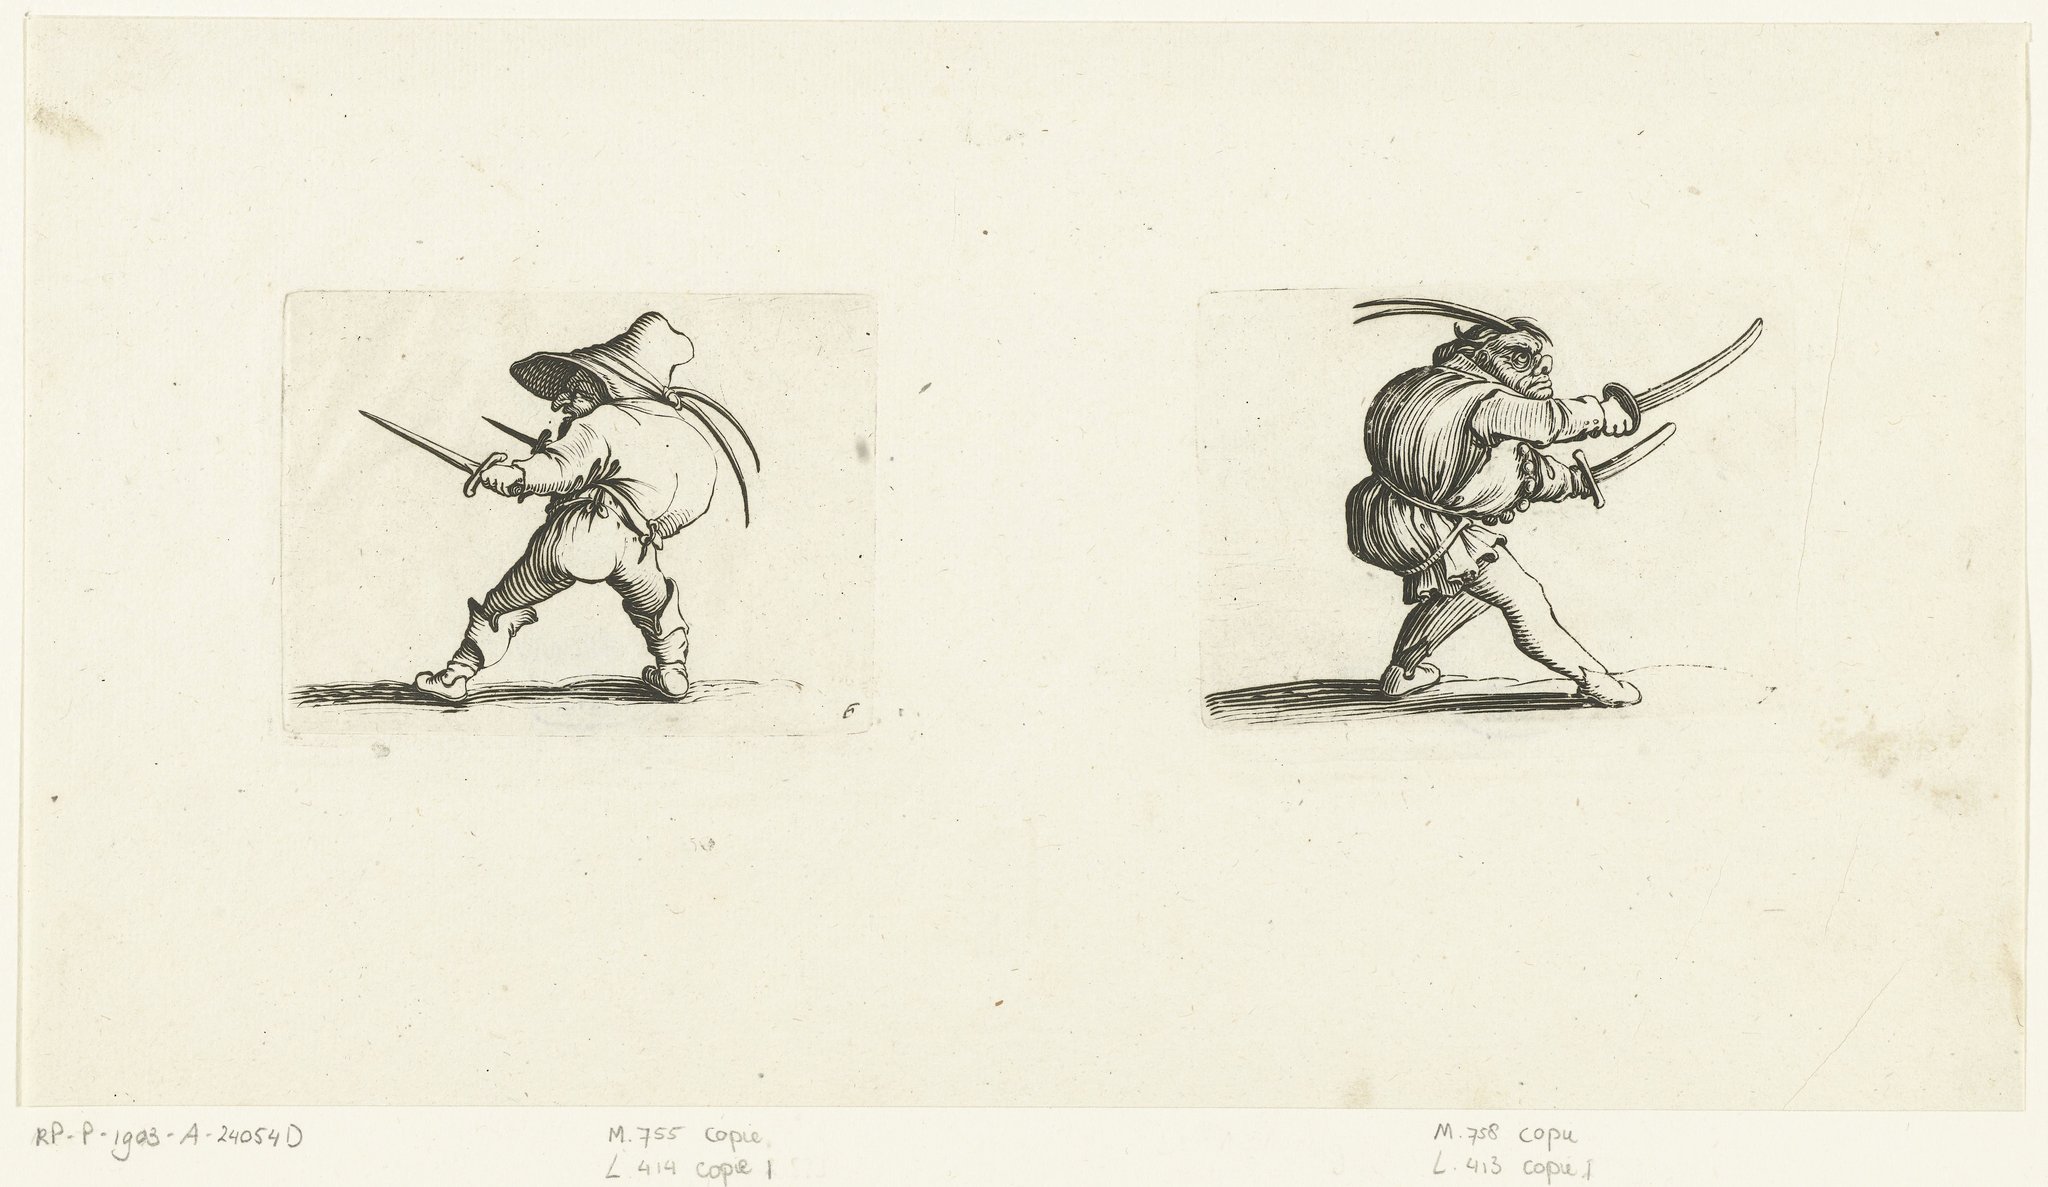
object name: print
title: Kleine mensen en gebochelden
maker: abraham bosse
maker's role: draughtsman, print maker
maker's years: 1602-1676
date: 1621-1676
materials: paper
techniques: engraving, etching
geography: paris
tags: little people, hacking and thrusting weapons: dagger, hacking and thrusting weapons: sword, hunchback, human beings (legendary or not) of abnormal proportions, size, strength, etc.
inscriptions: collector's mark: Lugt 2228a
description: Links: kleine mens (karikatuur), min of meer op de linkerzijde gezien, met een gebochelde rug, een hoed met twee veren op het hoofd, in de rechterhand en in de linkerhand een dolk. Rechts: groteske figuur, op de rechterzijde gezien, met een gebochelde rug, een muts met twee veren op het hoofd, in de rechterhand en in de linkerhand een zwaard. Deze beide prenten, naast elkaar op 1 blad gedrukt, zijn onderdeel van een serie van 21 prenten (op 11 bladen gedrukt, dus m.u.v. de titelprent steeds 2 platen per blad) met groteske figuren; vrijwel al die figuren zijn karikaturen van kleine mensen, velen zijn gebocheld.